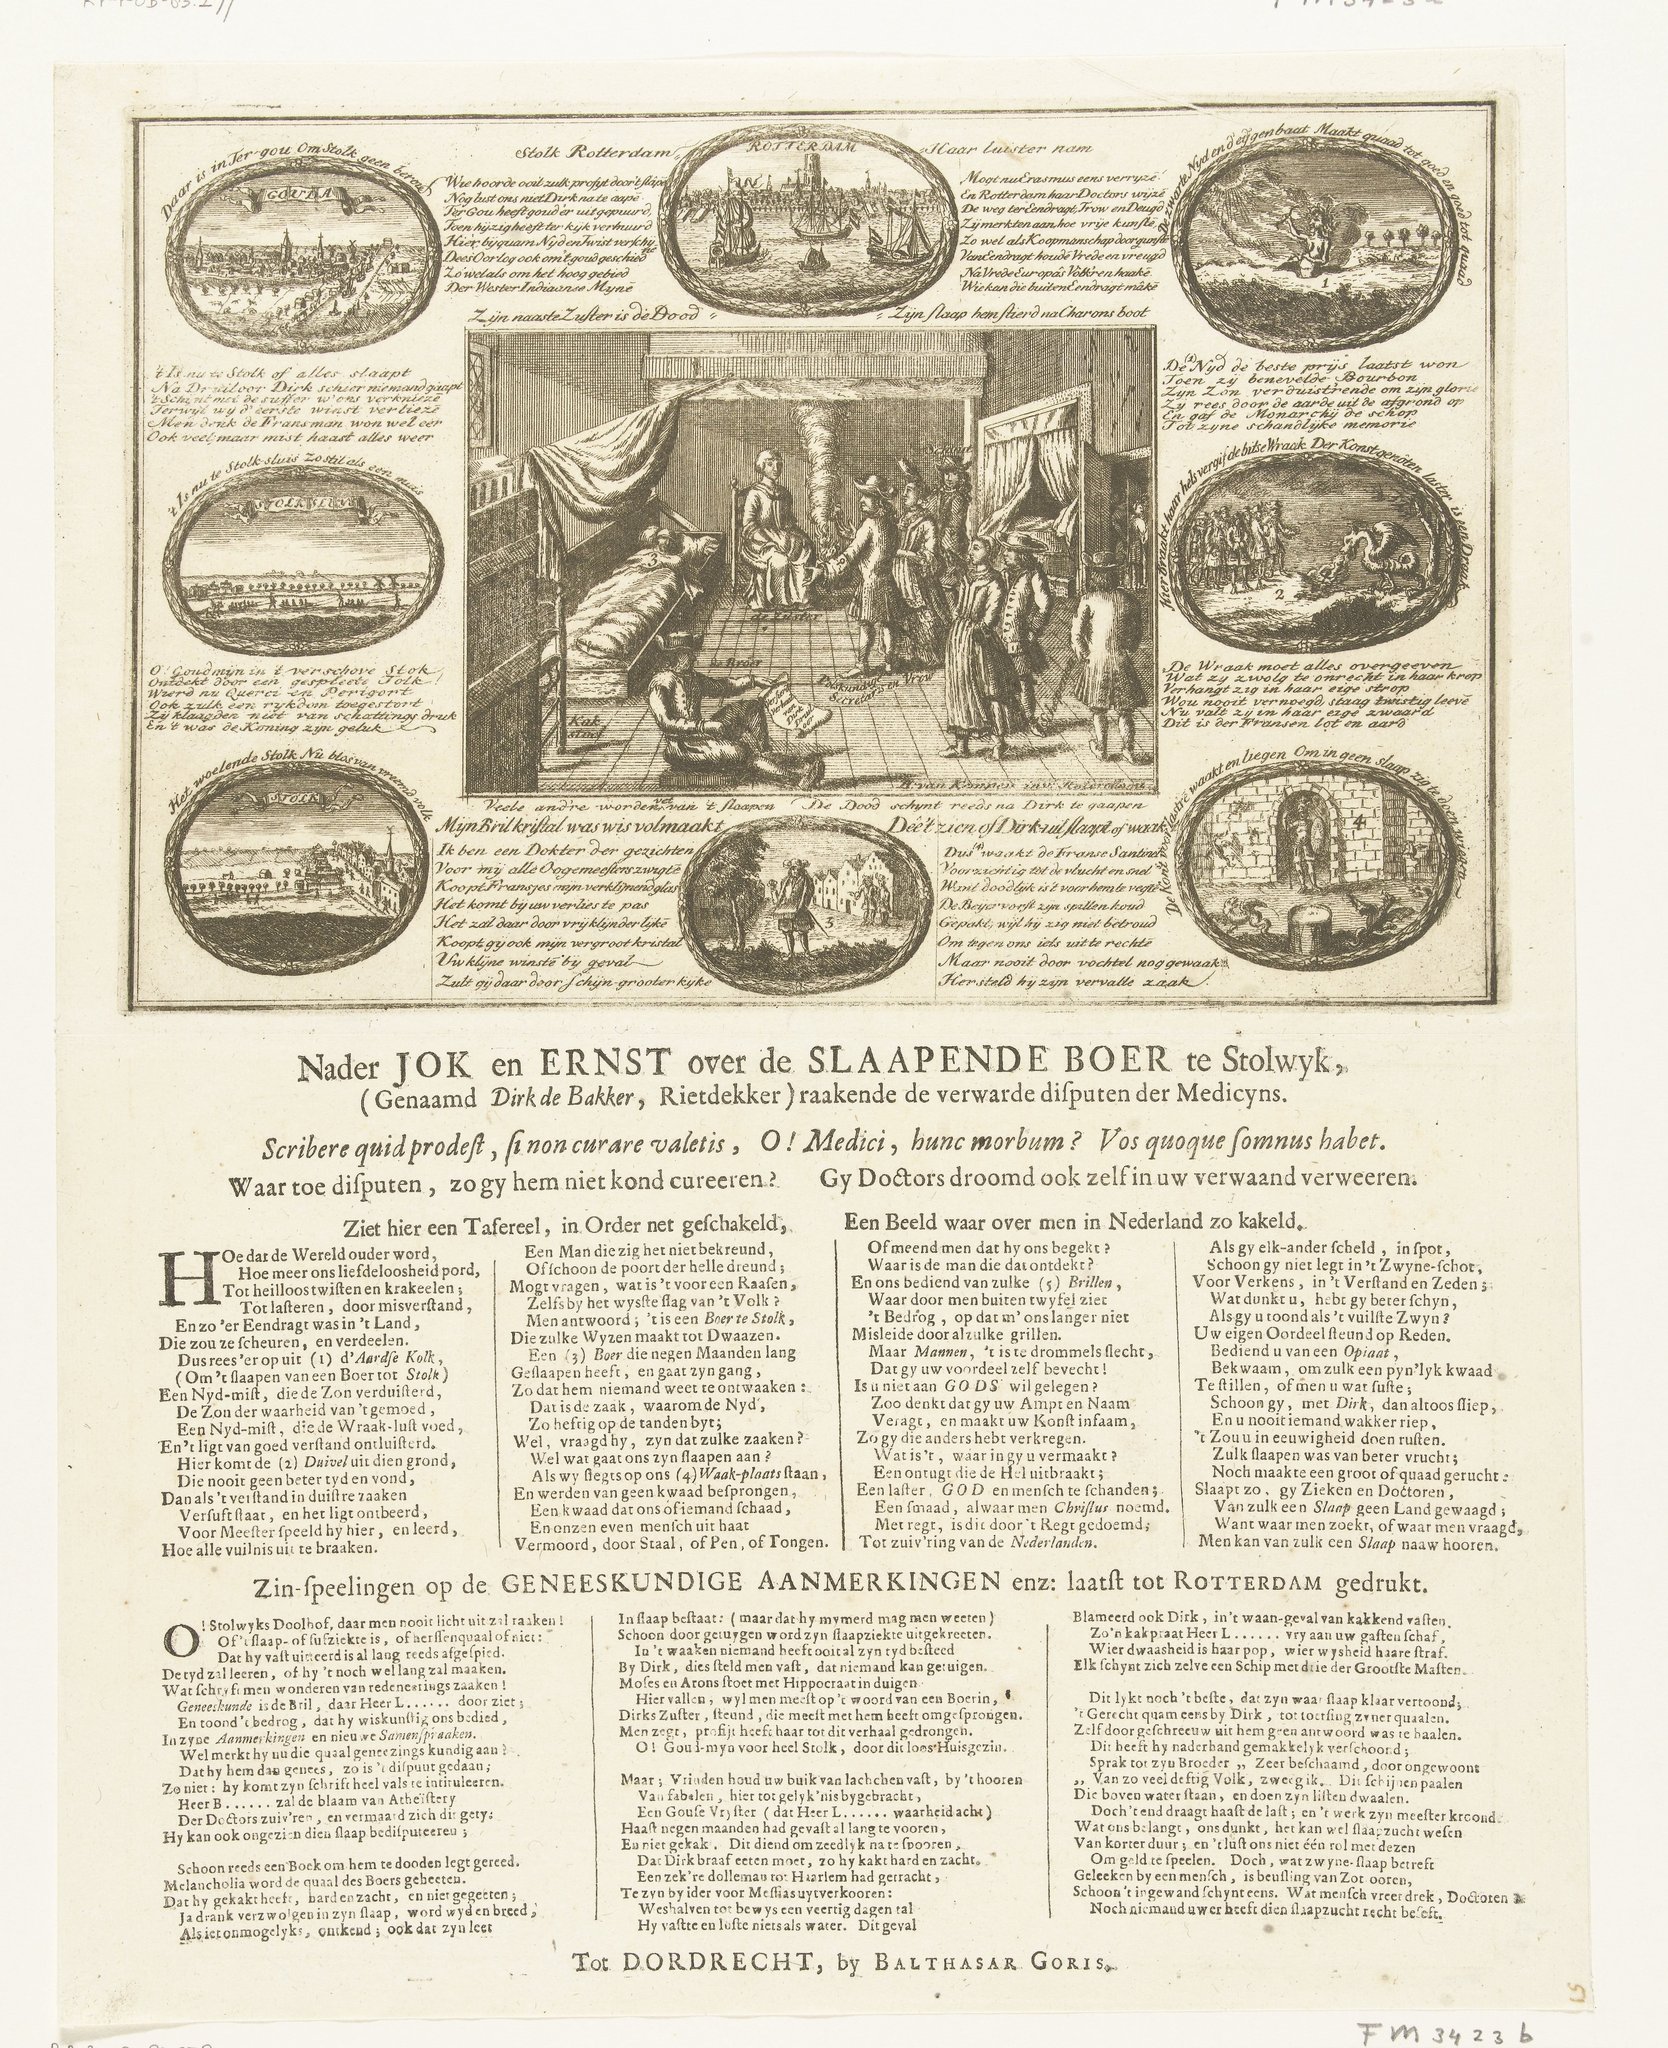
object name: cartoon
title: Nader Jok en Ernst over de Slaapende Boer van Stolwyk, (Genaamd Dirk de Bakker, Rietdekker) raakende de verwarde disputen der Medicyns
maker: carel allard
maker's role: print maker, publisher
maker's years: 1648-1709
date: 1707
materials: paper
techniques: etching, letterpress printing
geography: northern netherlands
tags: sleeping in bed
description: De slapende boer van Stolwijk (Dirk Klaasz de Bakker) gebruikt in een spotprent op de Fransen in het jaar 1707. Centraal het bed met de slapende man waaromheen artsen en toeschouwers staan verzameld. Deze voorstelling omringd door acht kleinere scènes met stadsgezichten en emblemen. Met opschriften in de plaat in het Nederlands. Vastgeplakt onder de plaat een blad met twee spotverzen.